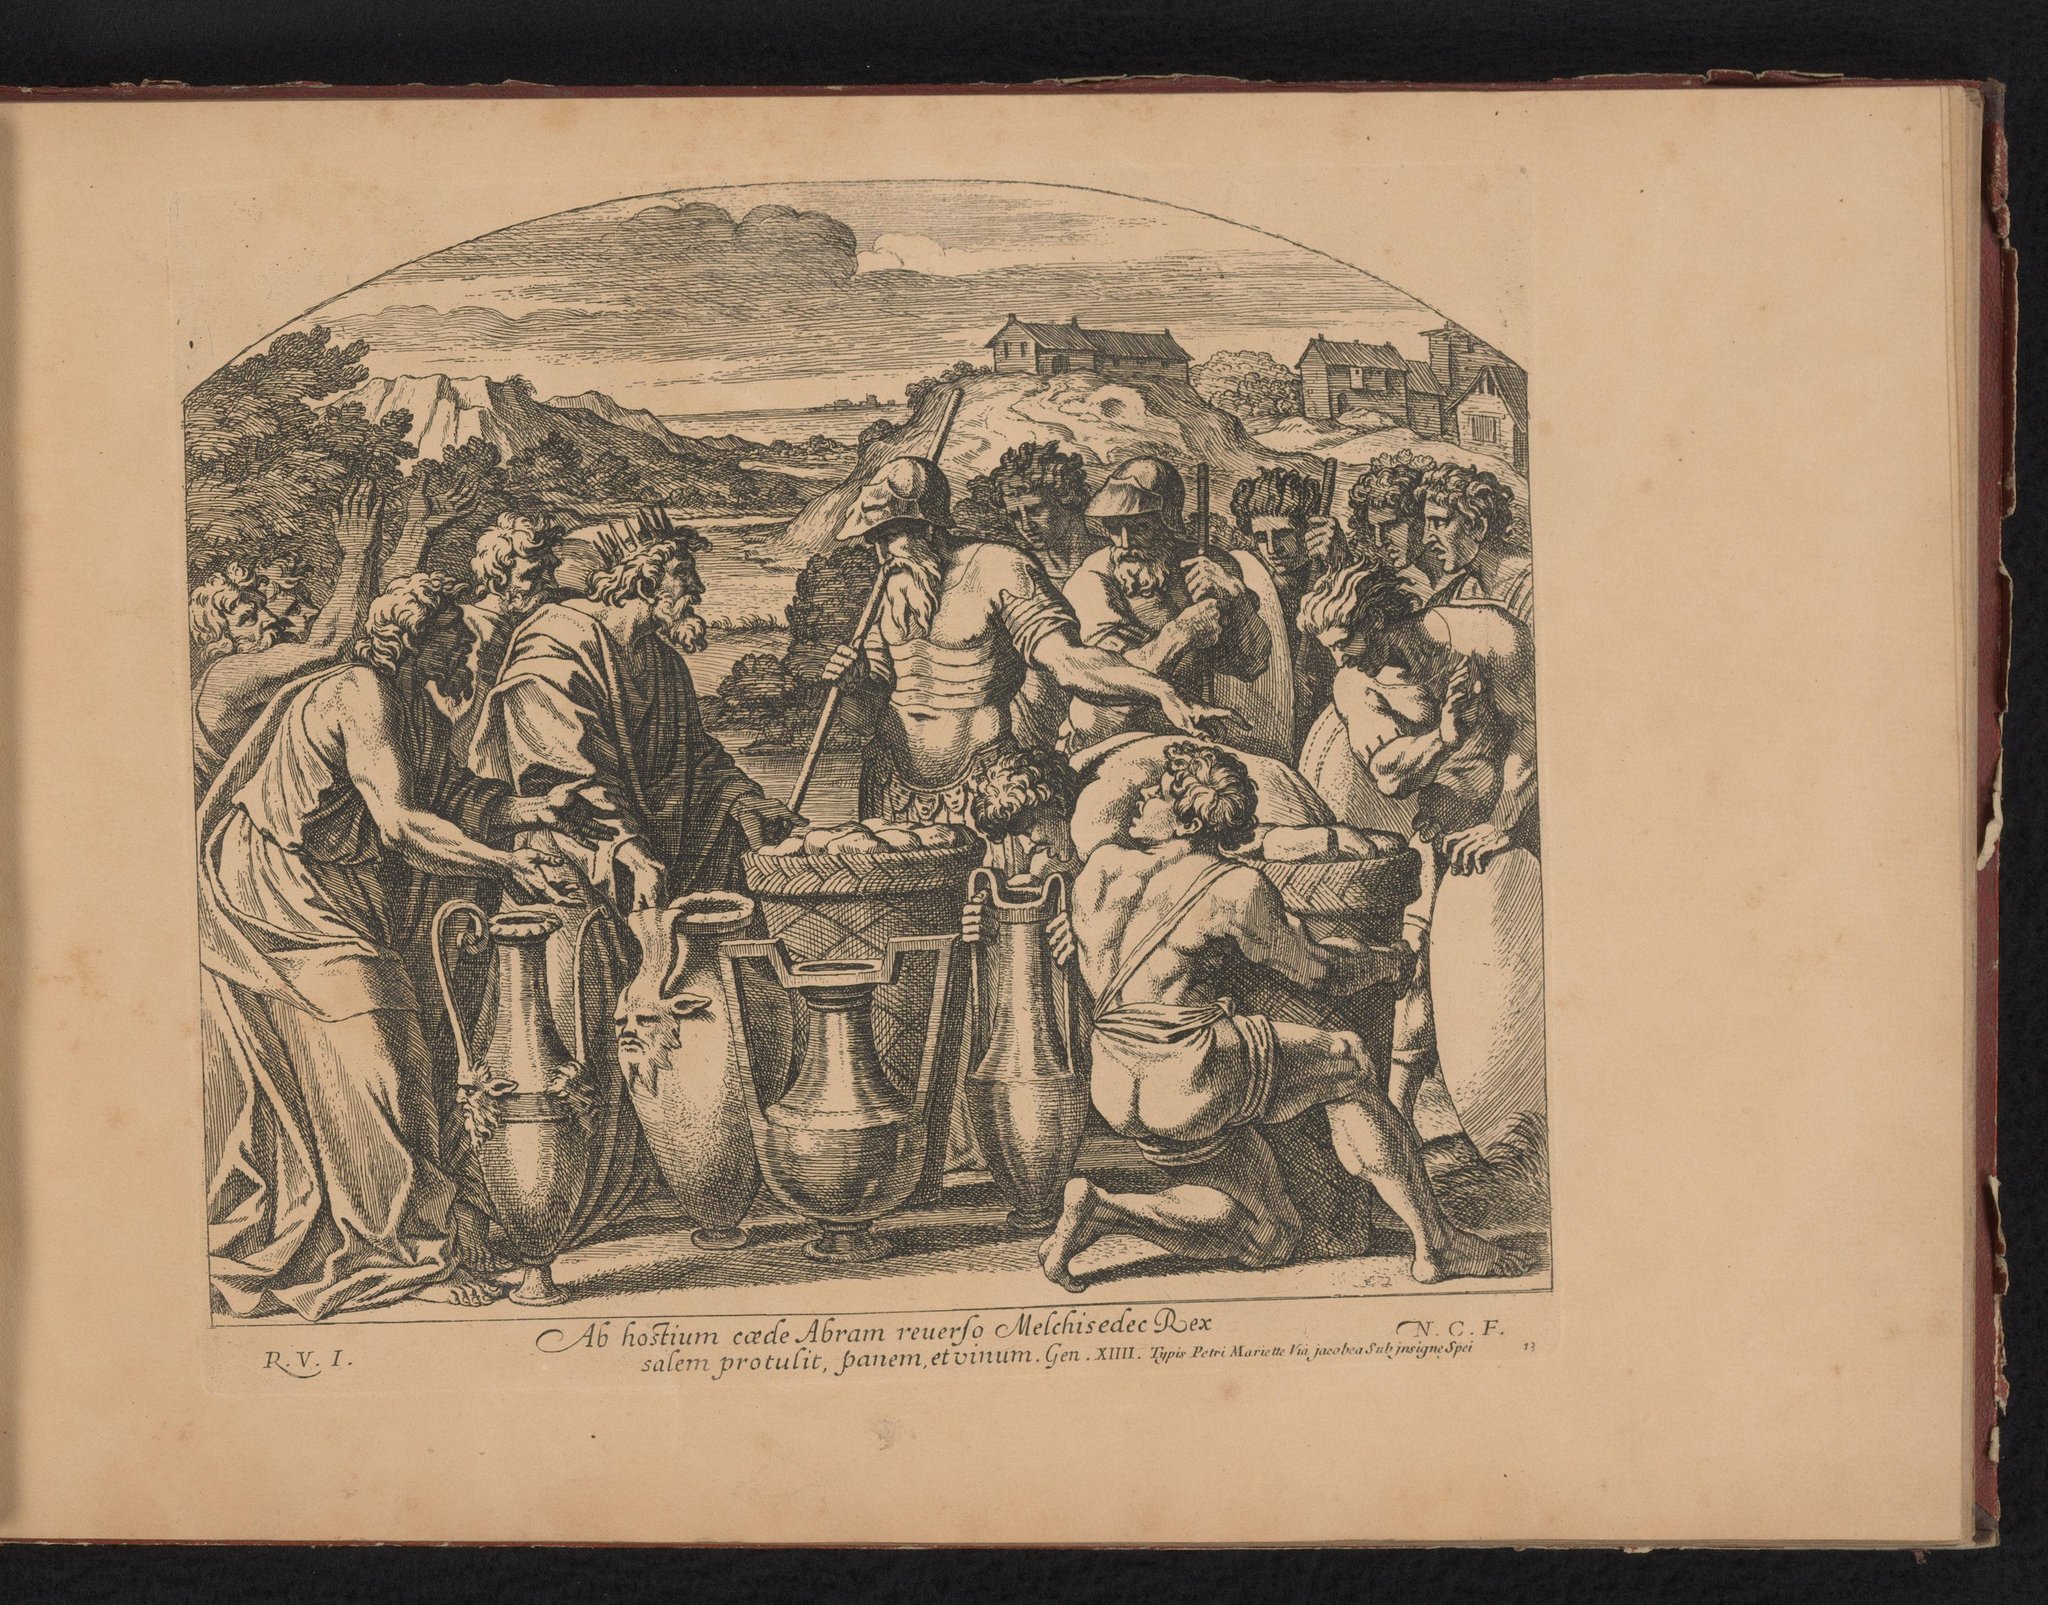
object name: print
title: Sacrae historiae acta a Raphael Urbin in Vaticanis xystis ad picturae miraculum expressa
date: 1649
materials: paper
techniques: etching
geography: paris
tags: noah's sacrifice; various animals are offered, possibly a lamb, a dove and a ram (often combined with the rainbow of the covenant)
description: Deze prent maakt deel uit van een album.